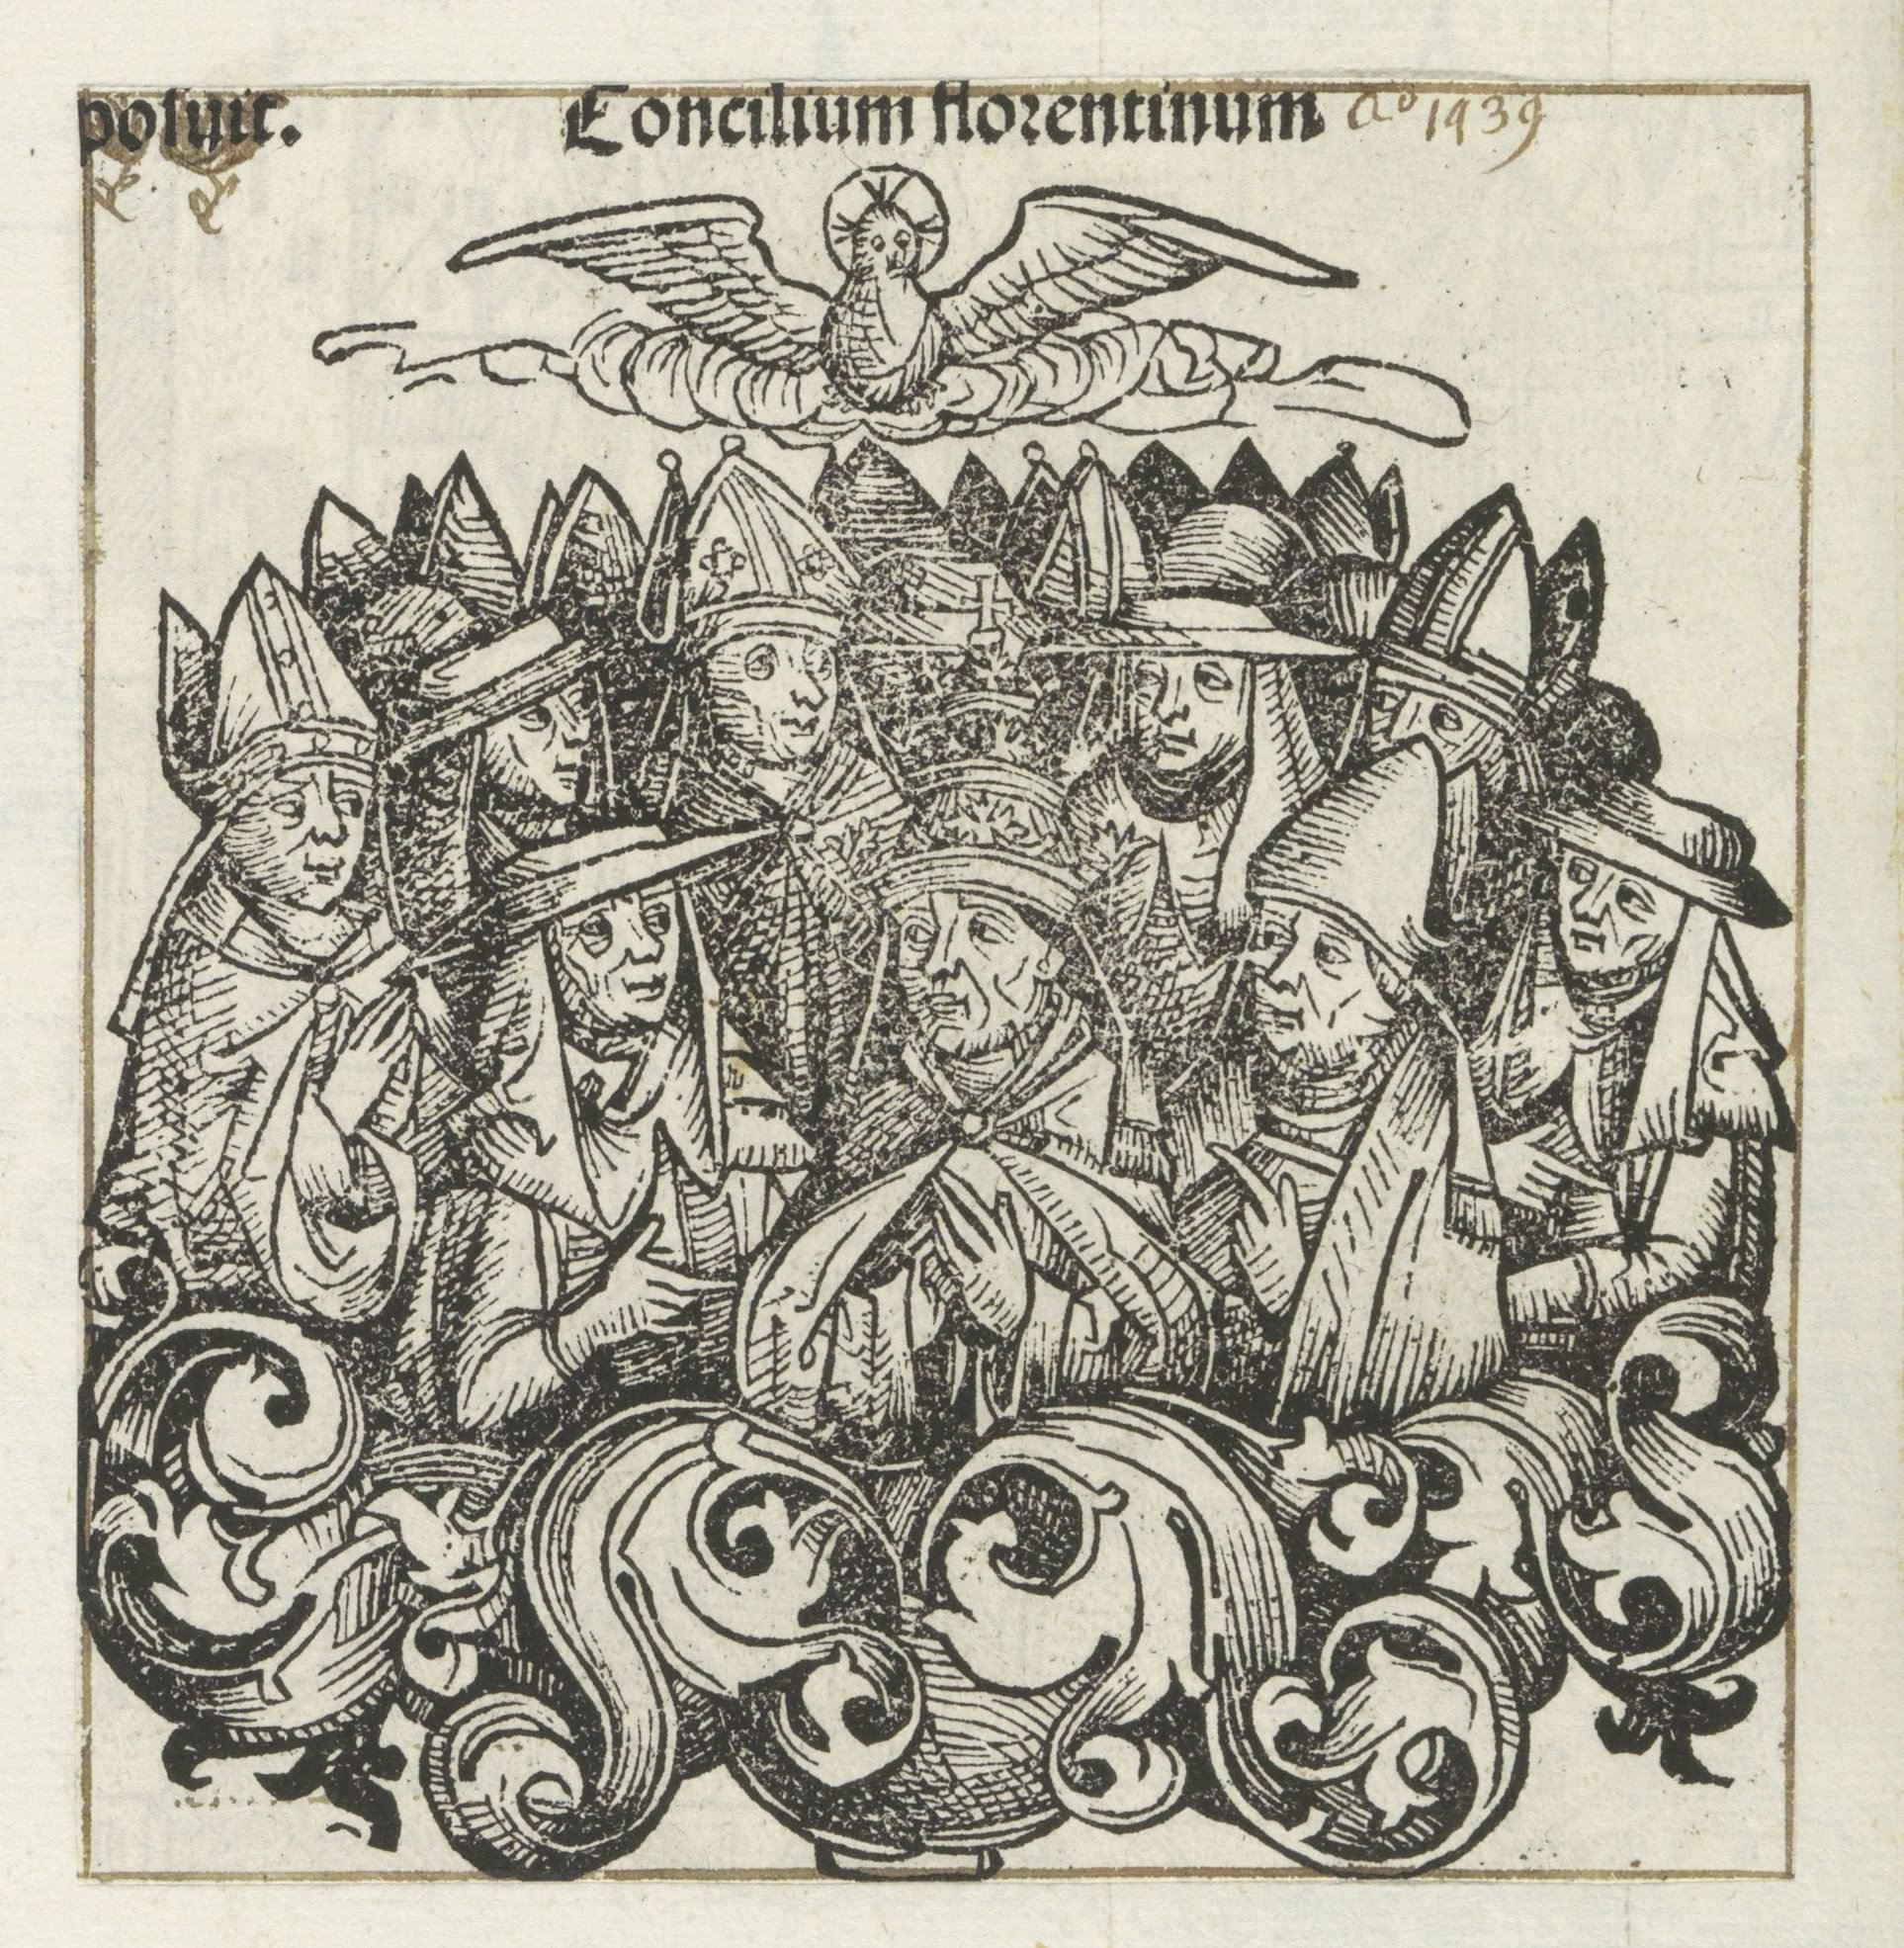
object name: album leaf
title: Concilium florentinum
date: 1493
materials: paper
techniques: letterpress printing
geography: nuremberg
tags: cardinal, council, synod ~ roman catholic church, pope, holy ghost represented as a dove (in flames)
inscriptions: inscription: ‘Ao 1439’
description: De houtsnede wordt herhaaldelijk gebruikt als boekillustratie in de Liber Chronicarum (of Neurenbergkroniek) van Hartmann Schedel, verschenen in het Latijn en Duits in 1493. Zie de Latijnse uitgave, folio 244v.